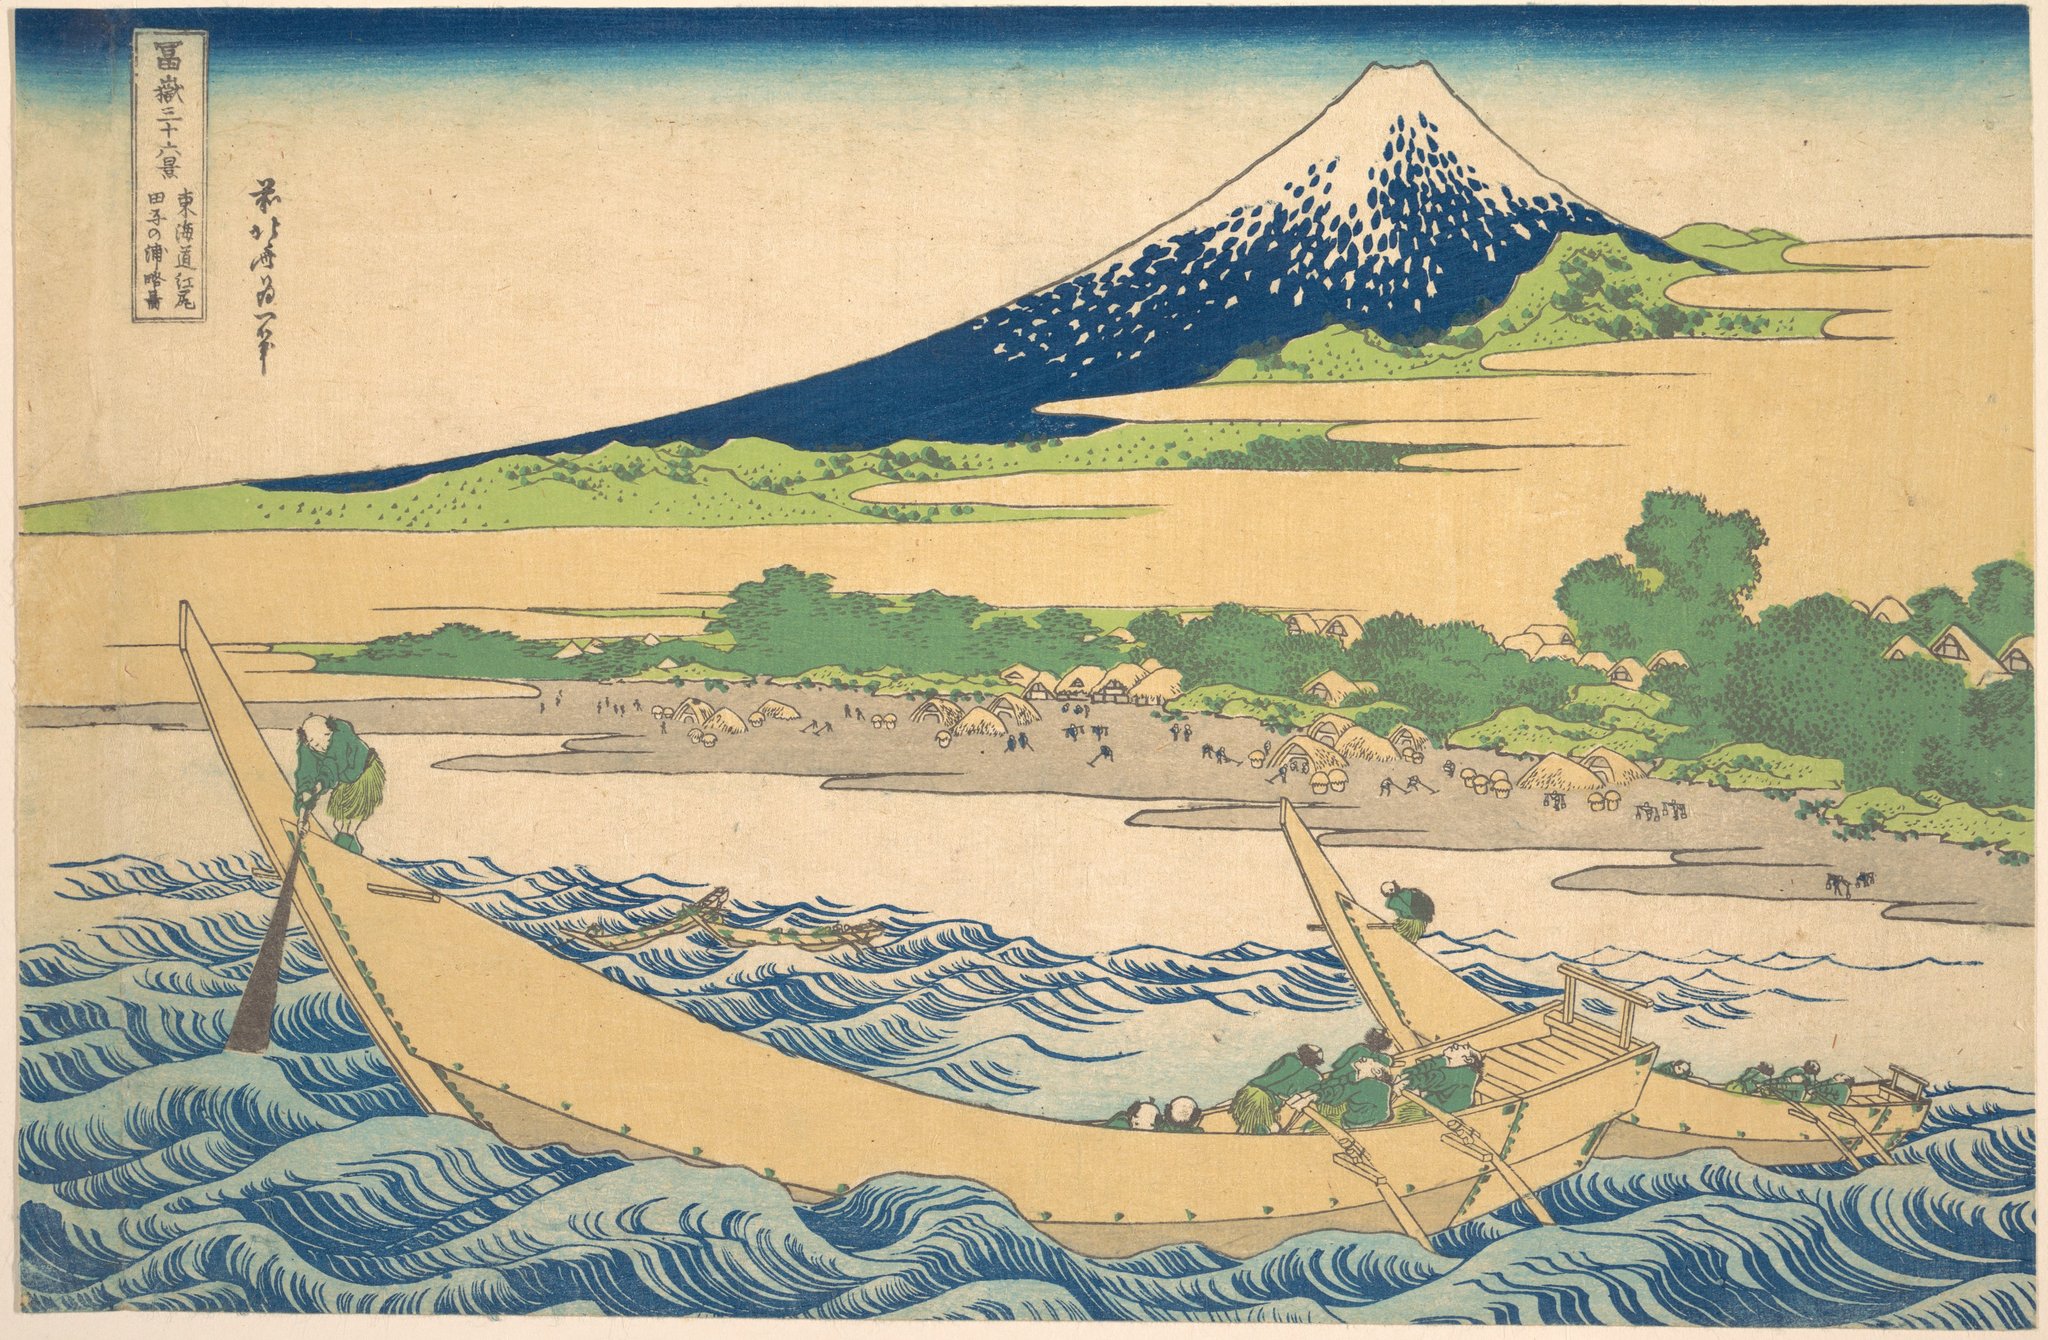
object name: woodblock print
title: Tago Bay near Ejiri on the Tōkaidō (Tōkaidō Ejiri Tago no ura ryaku zu), from the series Thirty-six Views of Mount Fuji (Fugaku sanjūrokkei)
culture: japanese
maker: katsushika hokusai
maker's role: artist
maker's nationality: japanese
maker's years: 1760-1849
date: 1830-1832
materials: ink, paper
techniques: woodblock print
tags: human figures,rivers,volcanoes,waves,boats